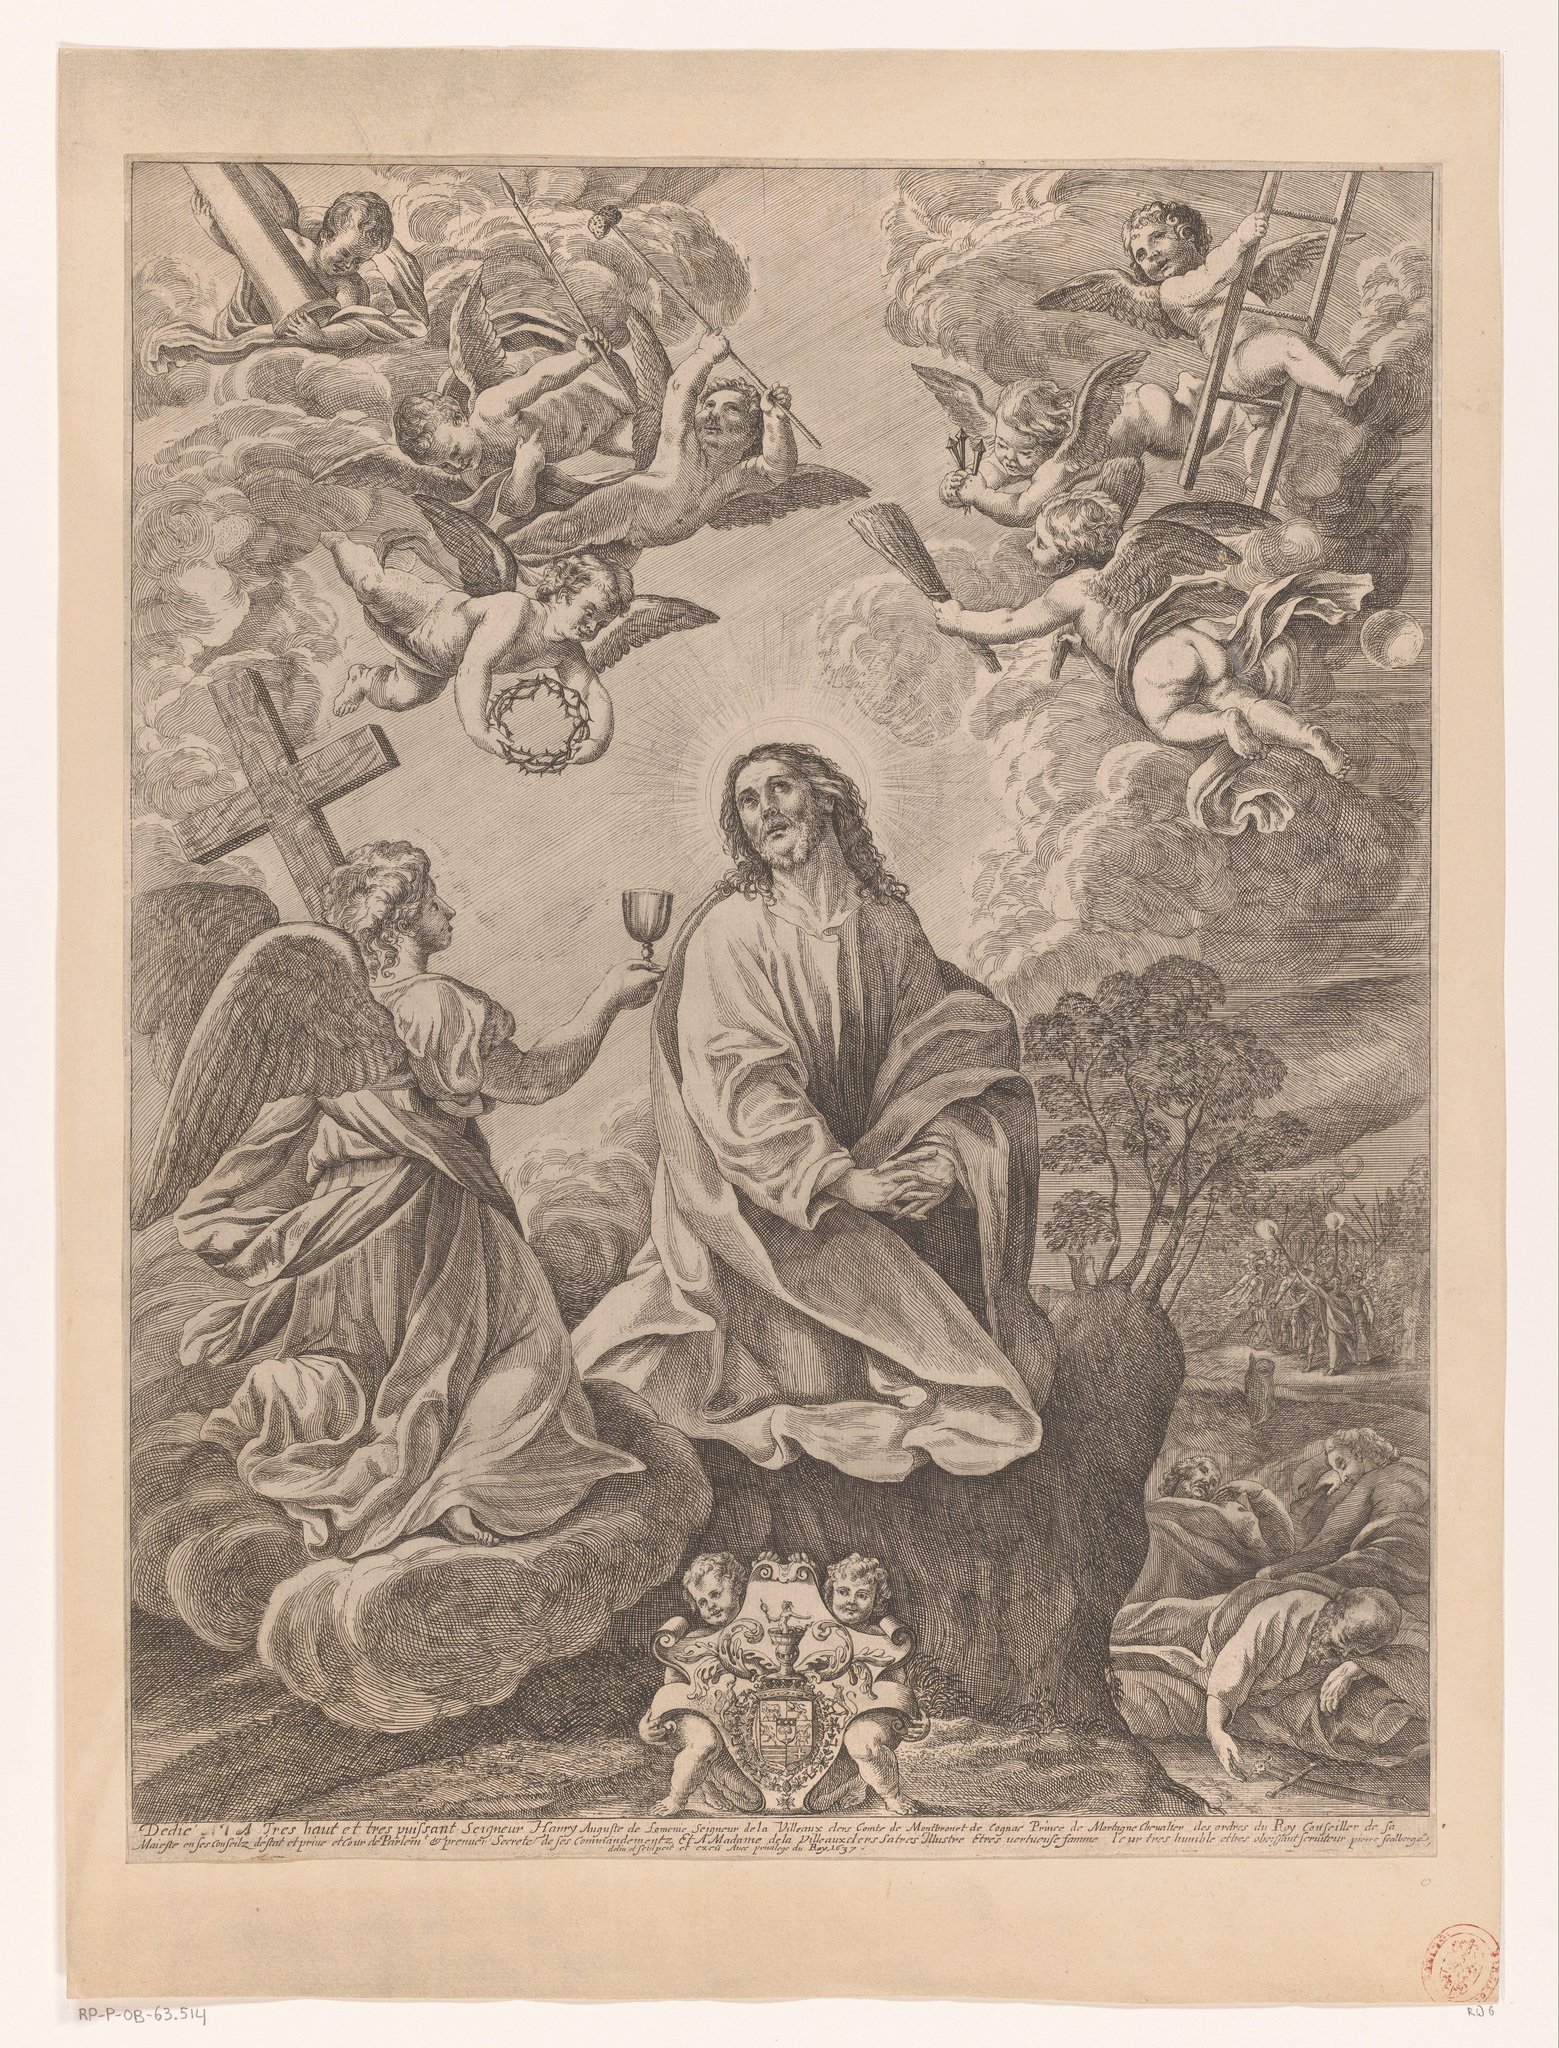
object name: print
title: Christus in de hof van Getsemane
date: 1637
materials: paper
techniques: etching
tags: christ and his apostles on the mount of olives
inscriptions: collector's mark: Lugt 240